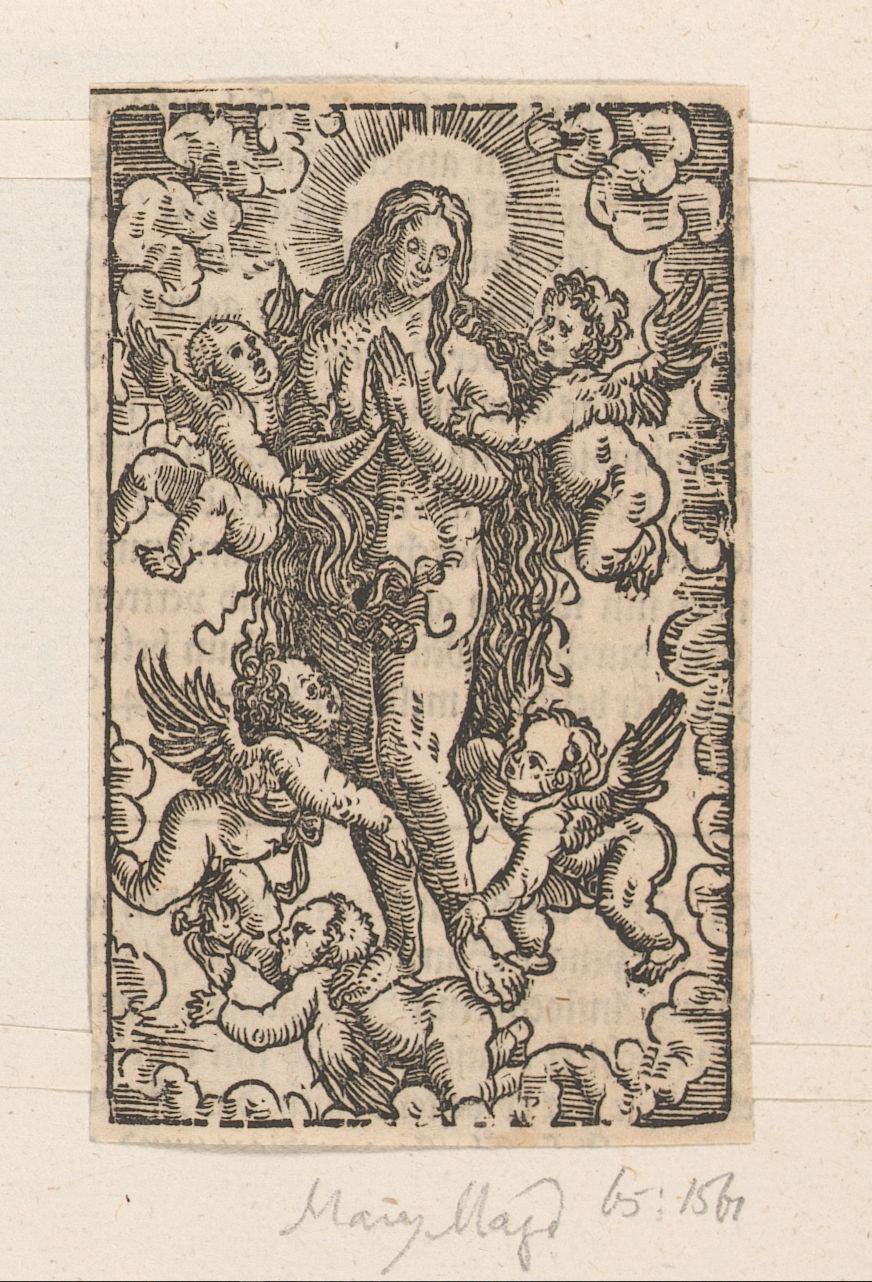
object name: print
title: Hemelvaart van Maria Magdalena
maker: Anonymous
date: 1500-1536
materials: paper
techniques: letterpress printing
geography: germany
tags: the assumption of st. mary magdalene: she is lifted up to heaven by angels; sometimes a hermit looks up at her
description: Maria Magdalena wordt door engelen naar de hemel gedragen. Prent maakt deel uit van een album.